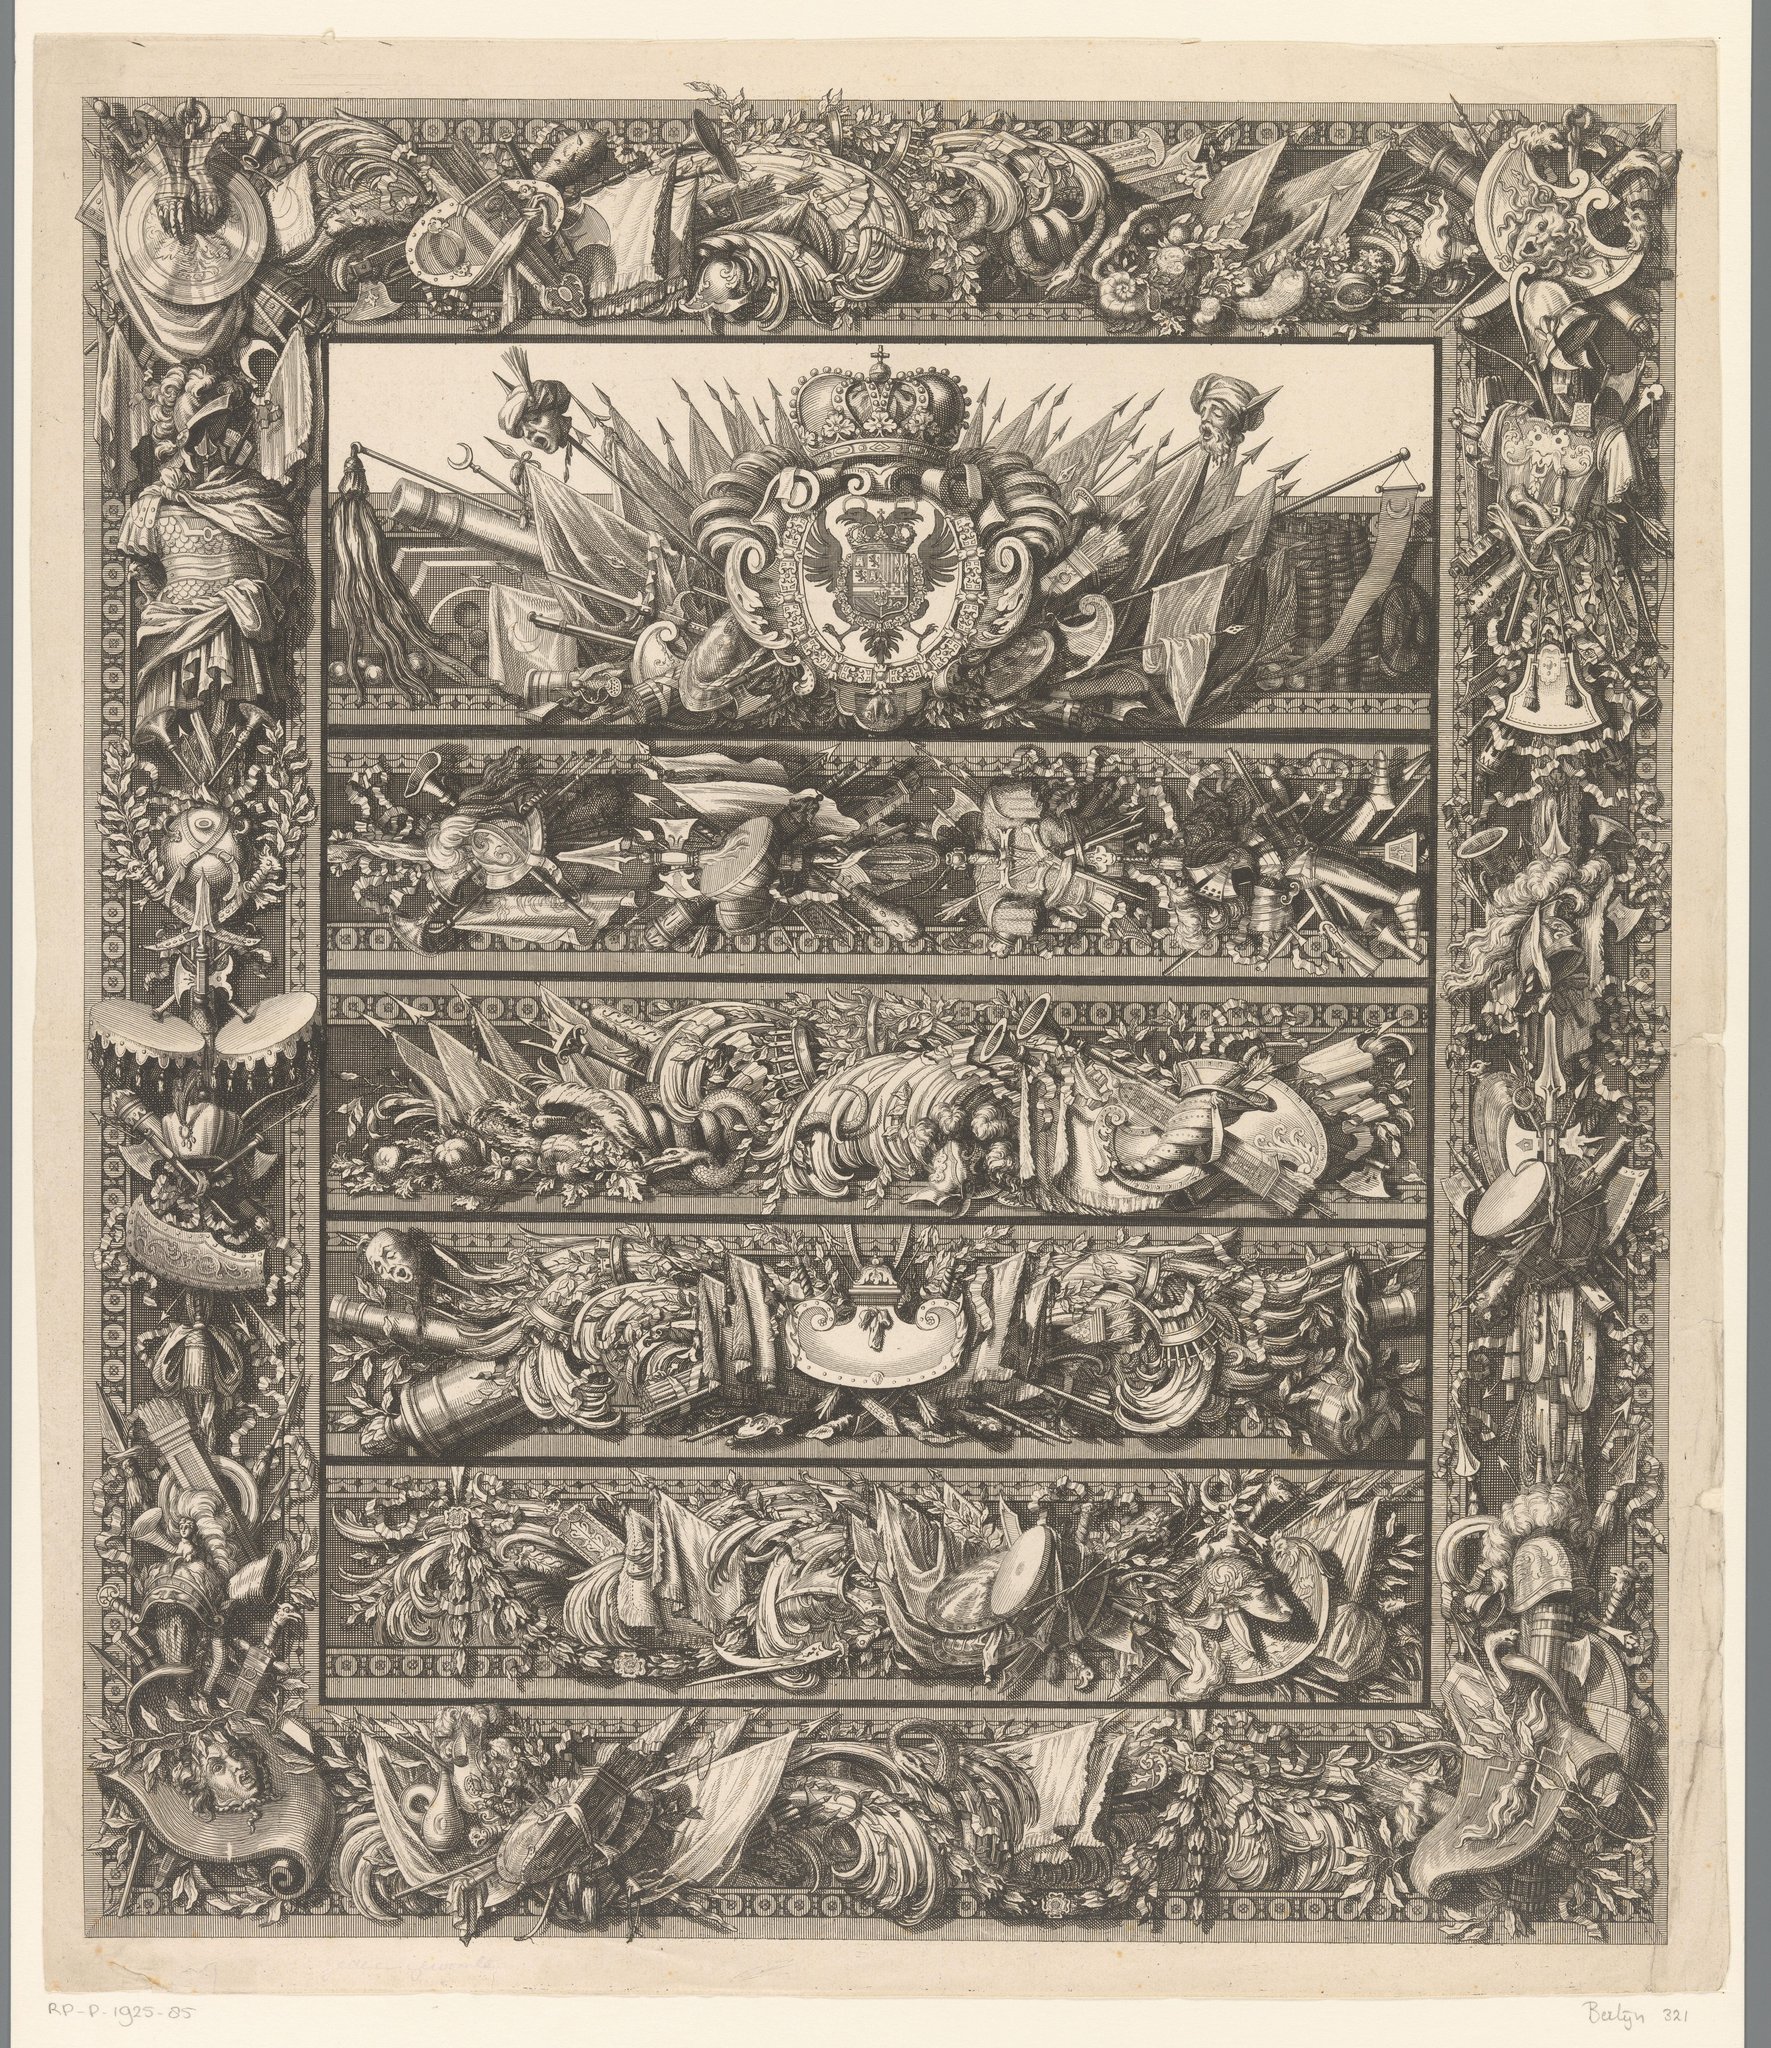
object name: ornament print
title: Friezen met wapentrofeeën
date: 1665-1700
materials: paper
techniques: etching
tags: 'tropaion', i.e. decorative ornament ~ weapons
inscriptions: collector's mark: Lugt 2233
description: Vijf friezen met wapentrofeeën omringd door een omlijsting van wapentrofeeën. In het bovenste fries een gekroond wapenschild met het wapen van Spanje.